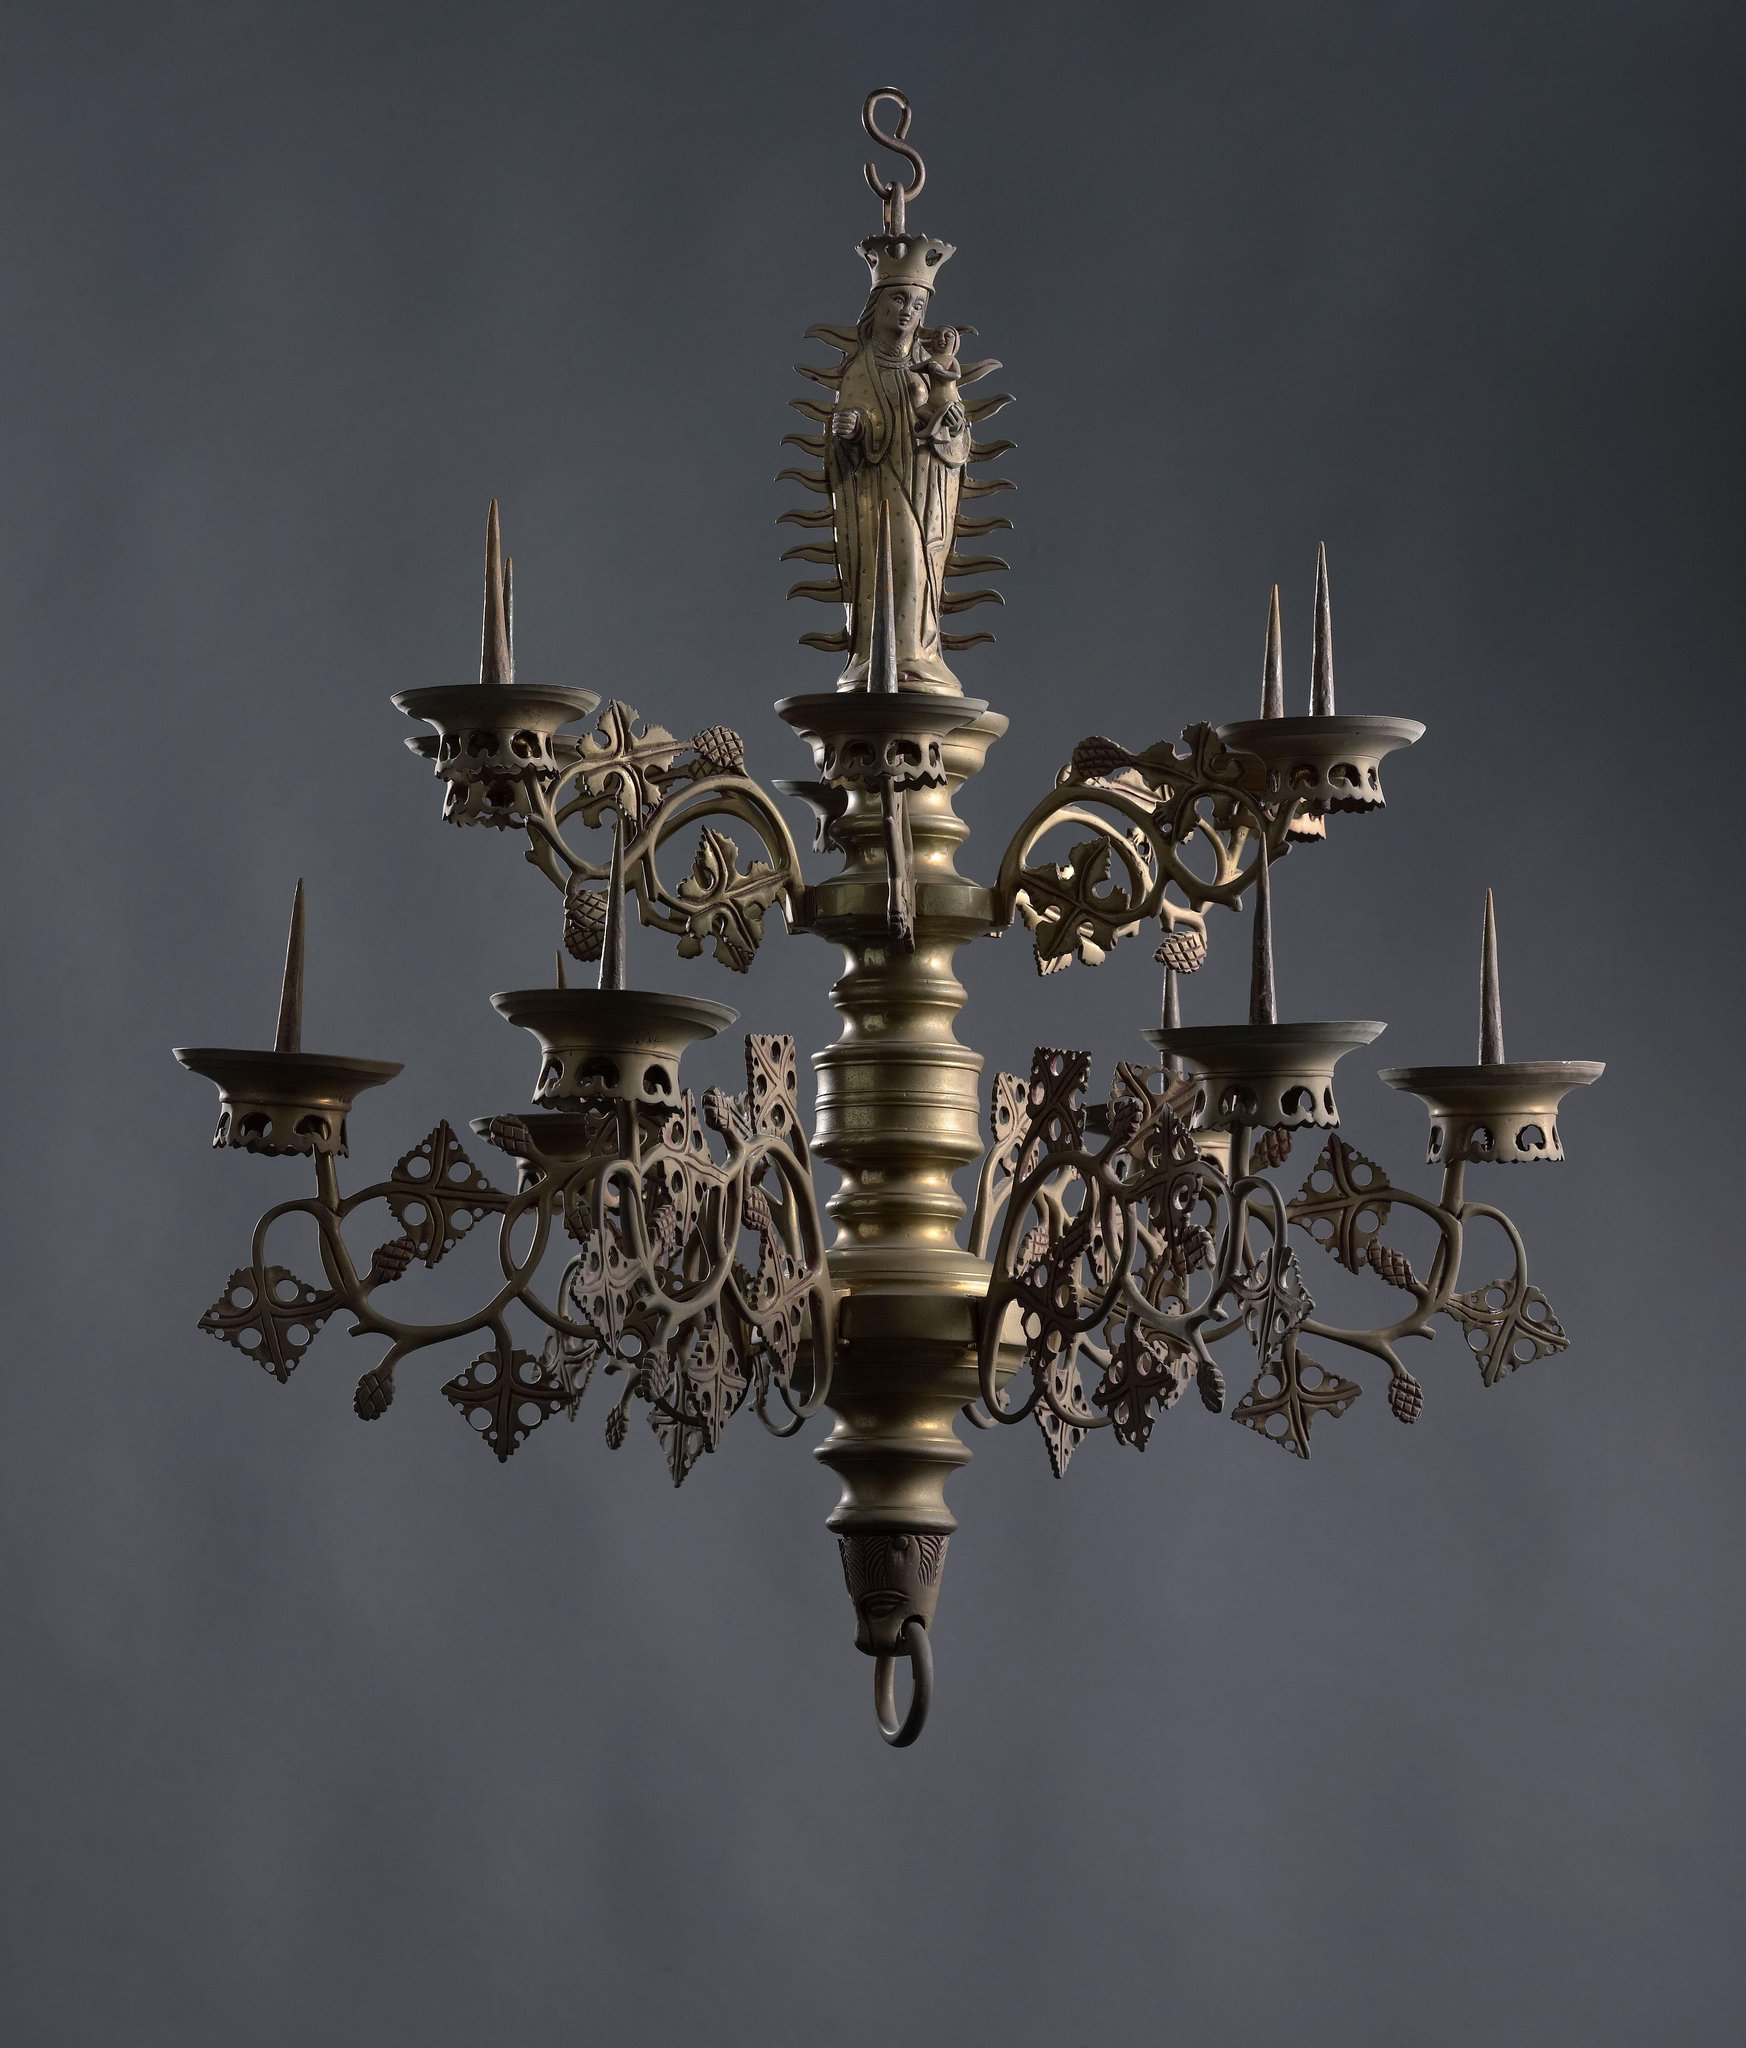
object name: chandelier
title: Arm met kaarsenhouder van kaarsenkroon van twee hoogten met ieder zes armen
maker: Anonymous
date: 1475-1500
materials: brass, iron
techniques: casting, metalworking, forging, screwed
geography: southern netherlands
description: Kaarsenarm behorende bij een kaarsenkroon van twee hoogten met Mariafiguur bovenaan. De arm is twee maal gebogen en is versierd met twee druiventrossen en twee wingerdbladeren. De ronde vetvanger heeft aan de onderkant opengewerkte, gekartelde verticaal geplaatste randen, ter maskering van de bevestiging op de arm. Dit geschiedt door een ronde ijzeren pin, die in het einde van de arm is geschroefd. Dit is de vijfde arm van de bovenste ring, genummerd met 5 verticale inkepingen. De vetvanger is ongenummerd.